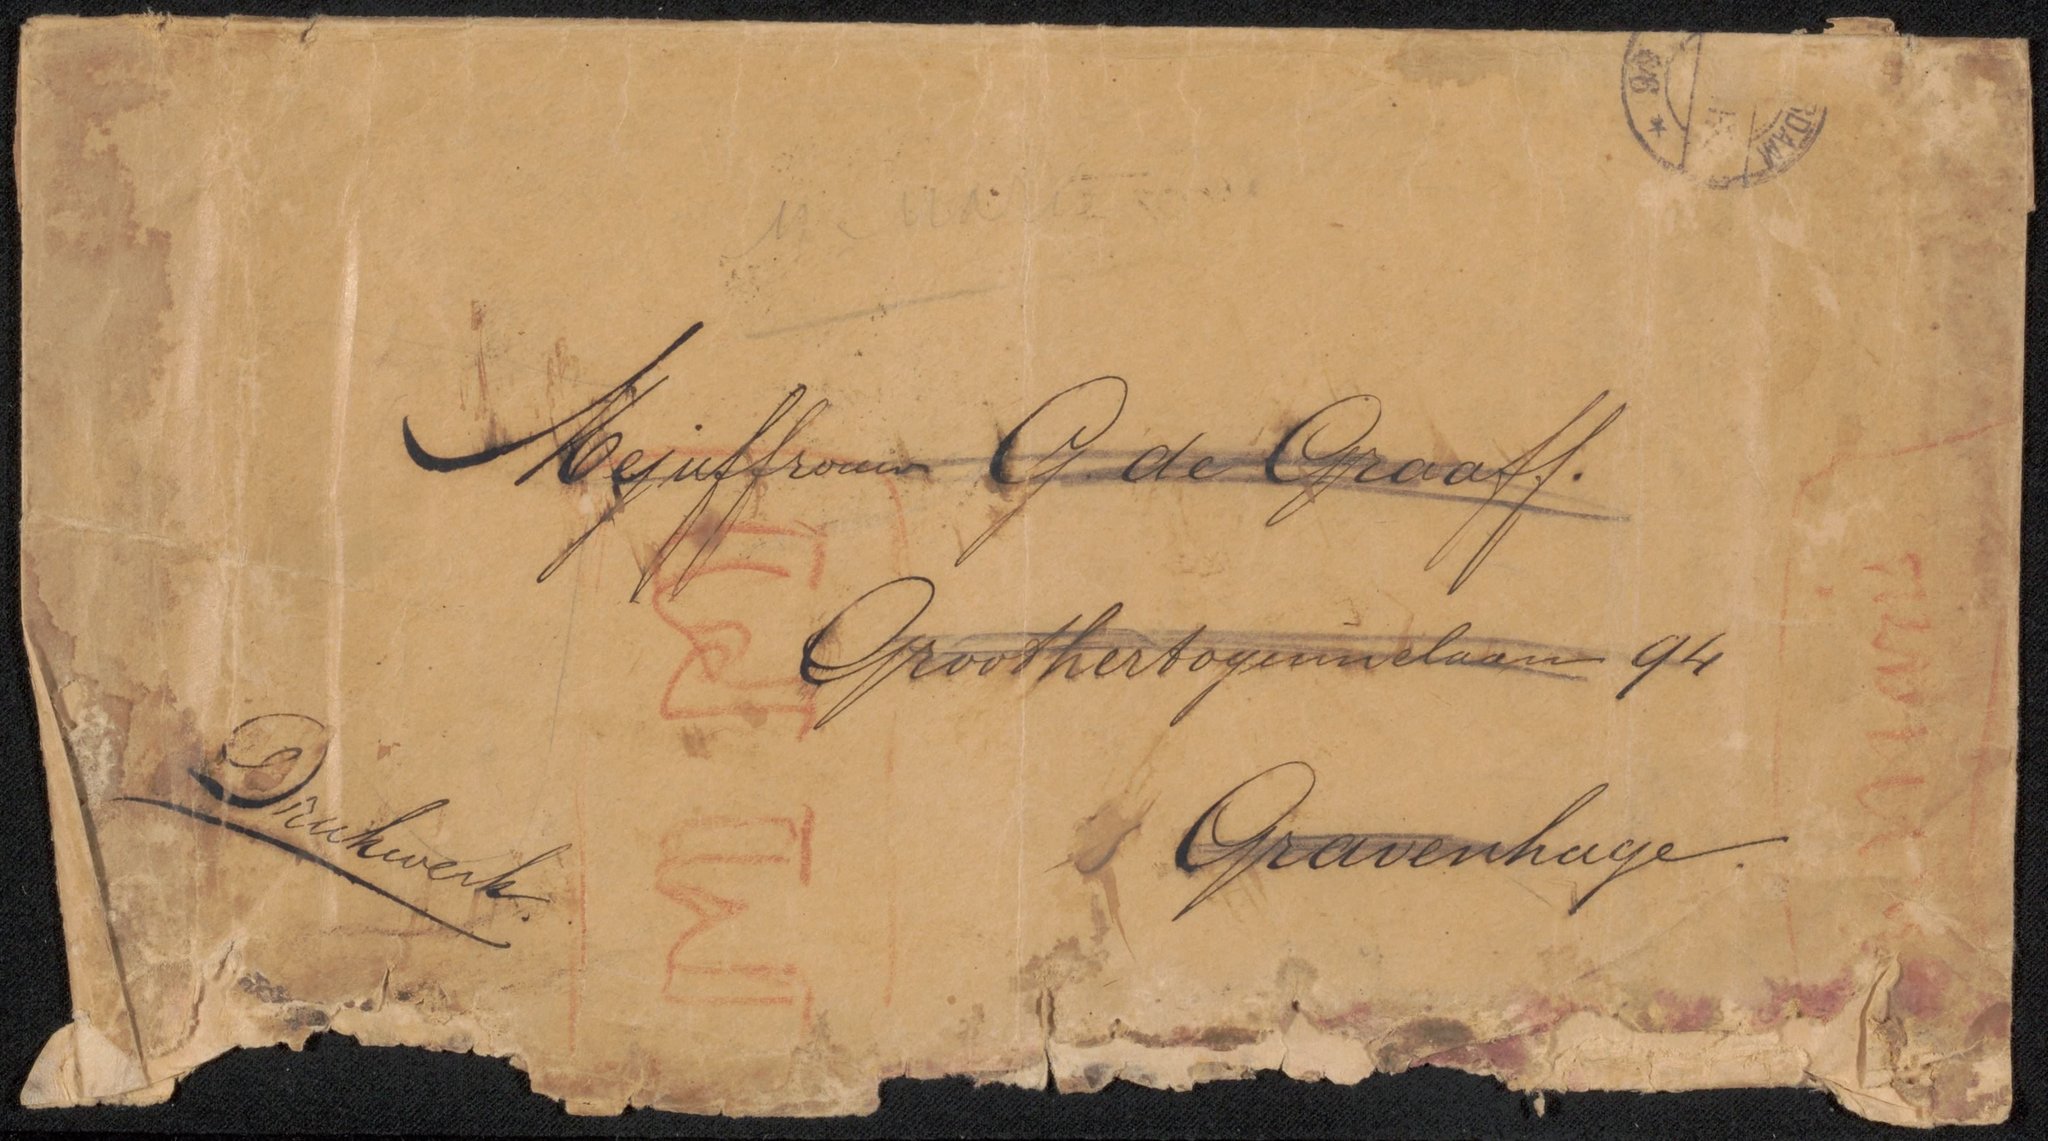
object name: envelope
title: Envelop aan Geertruid de Graaff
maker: Anonymous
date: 1812-1899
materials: ink, paper, pencil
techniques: pen, writing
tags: venlo, boekbinder, geertruid de graaff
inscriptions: collector's mark: ‘RPK’